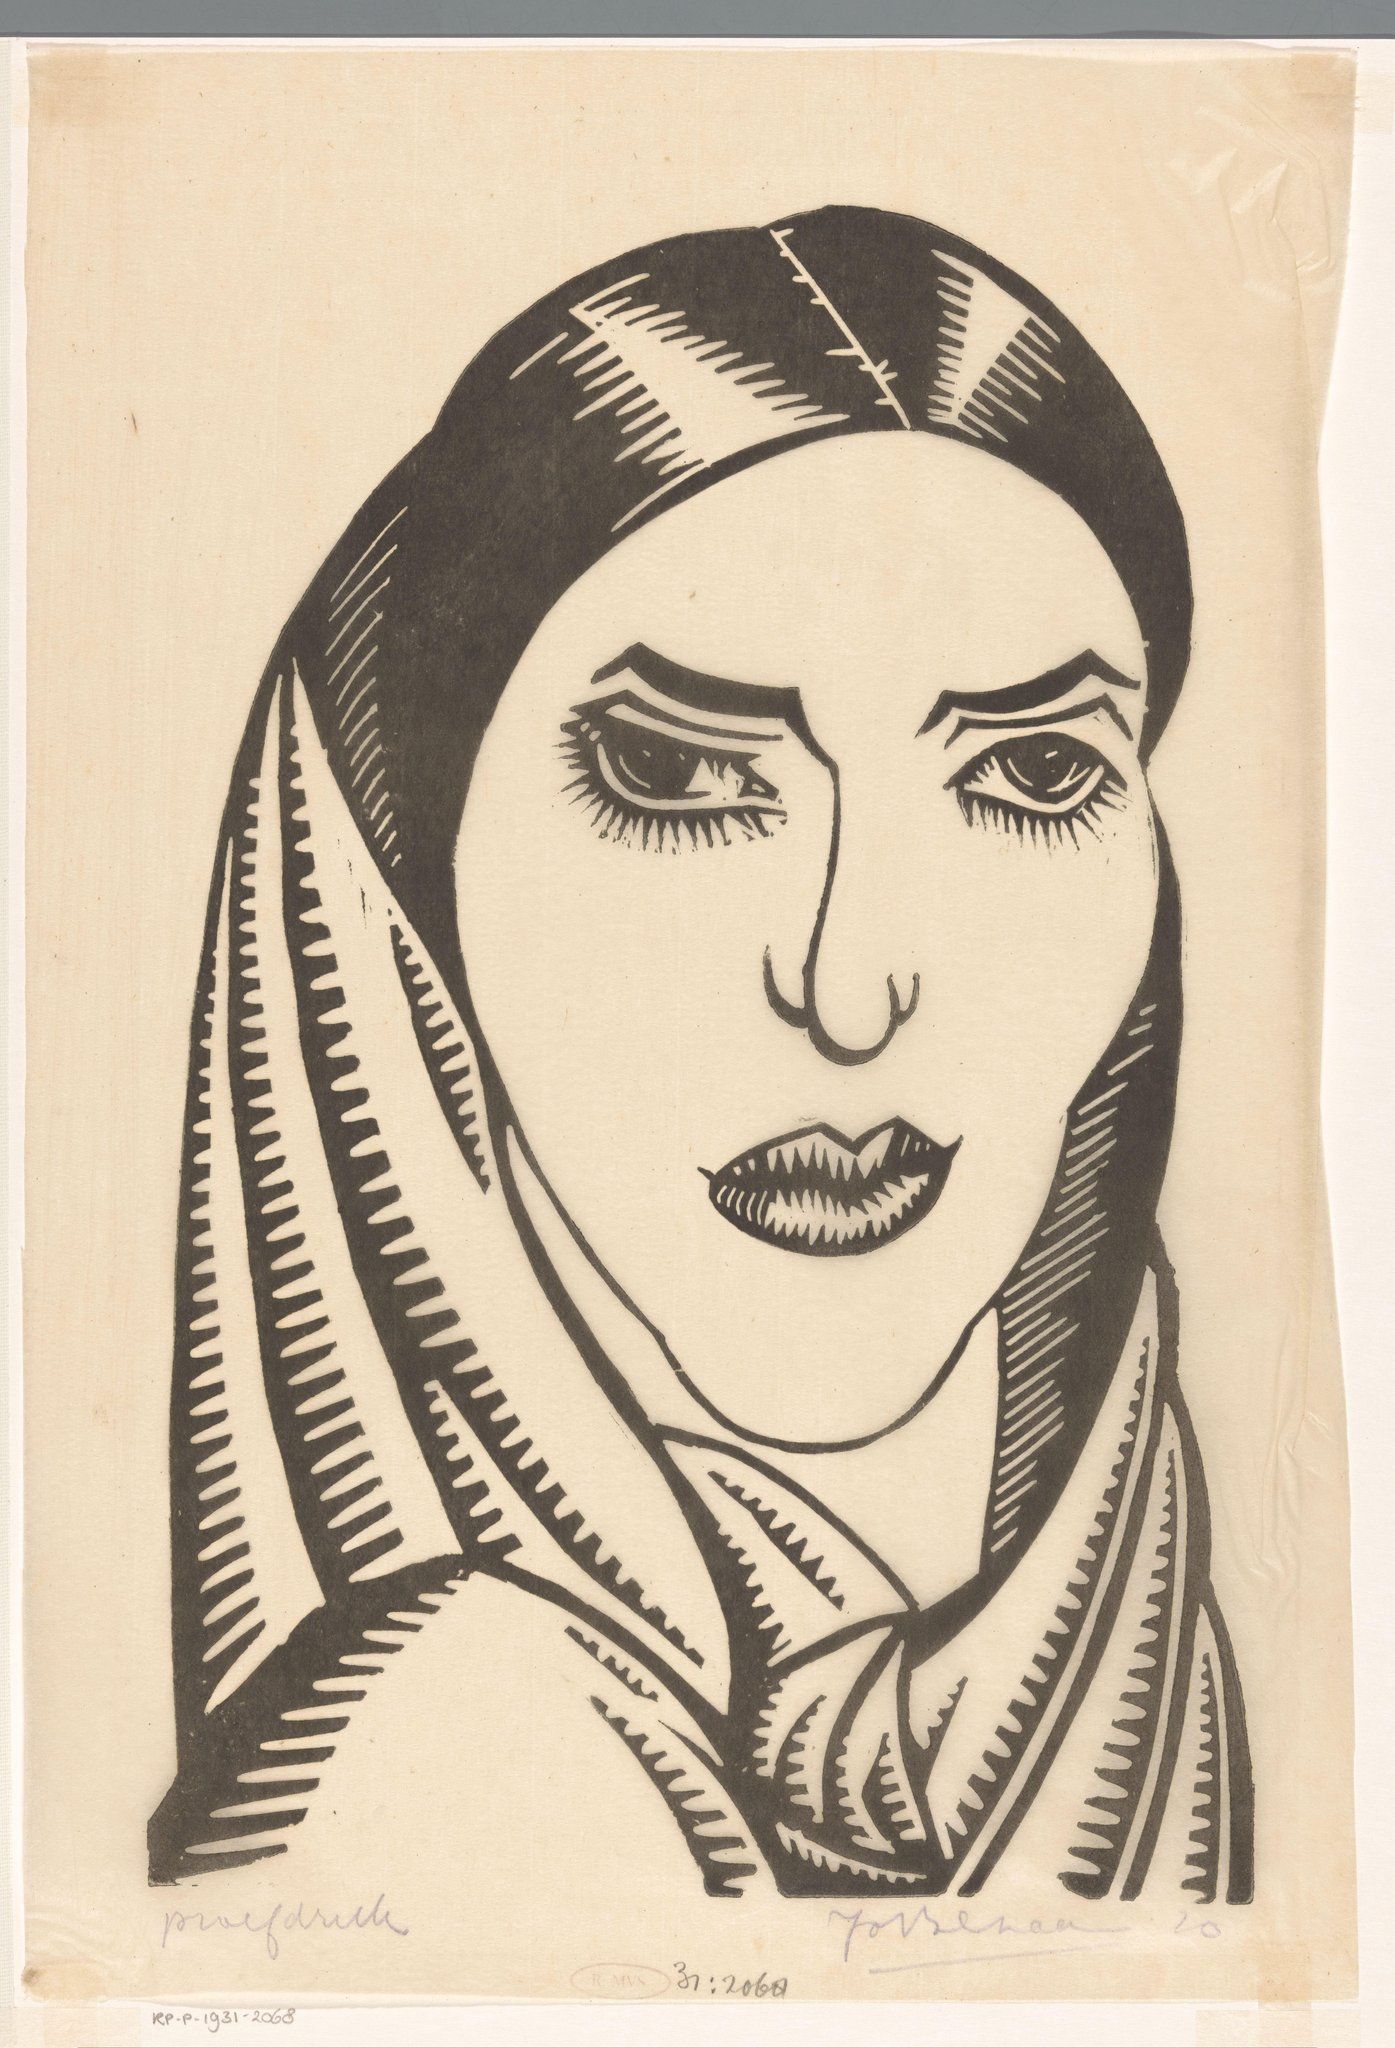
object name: print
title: Vrouw met hoofddoek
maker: jo bezaan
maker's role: draughtsman, print maker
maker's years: 1894-1952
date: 1920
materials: paper, ink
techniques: woodcut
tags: head-gear (with name)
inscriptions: inscription: ‘proefdruk’, signature and date: ‘JoBezaan 20’, collector's mark: Lugt 2228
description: Schouderstuk van een jonge vrouw met donker haar, een hoofddoek en een lui oog.